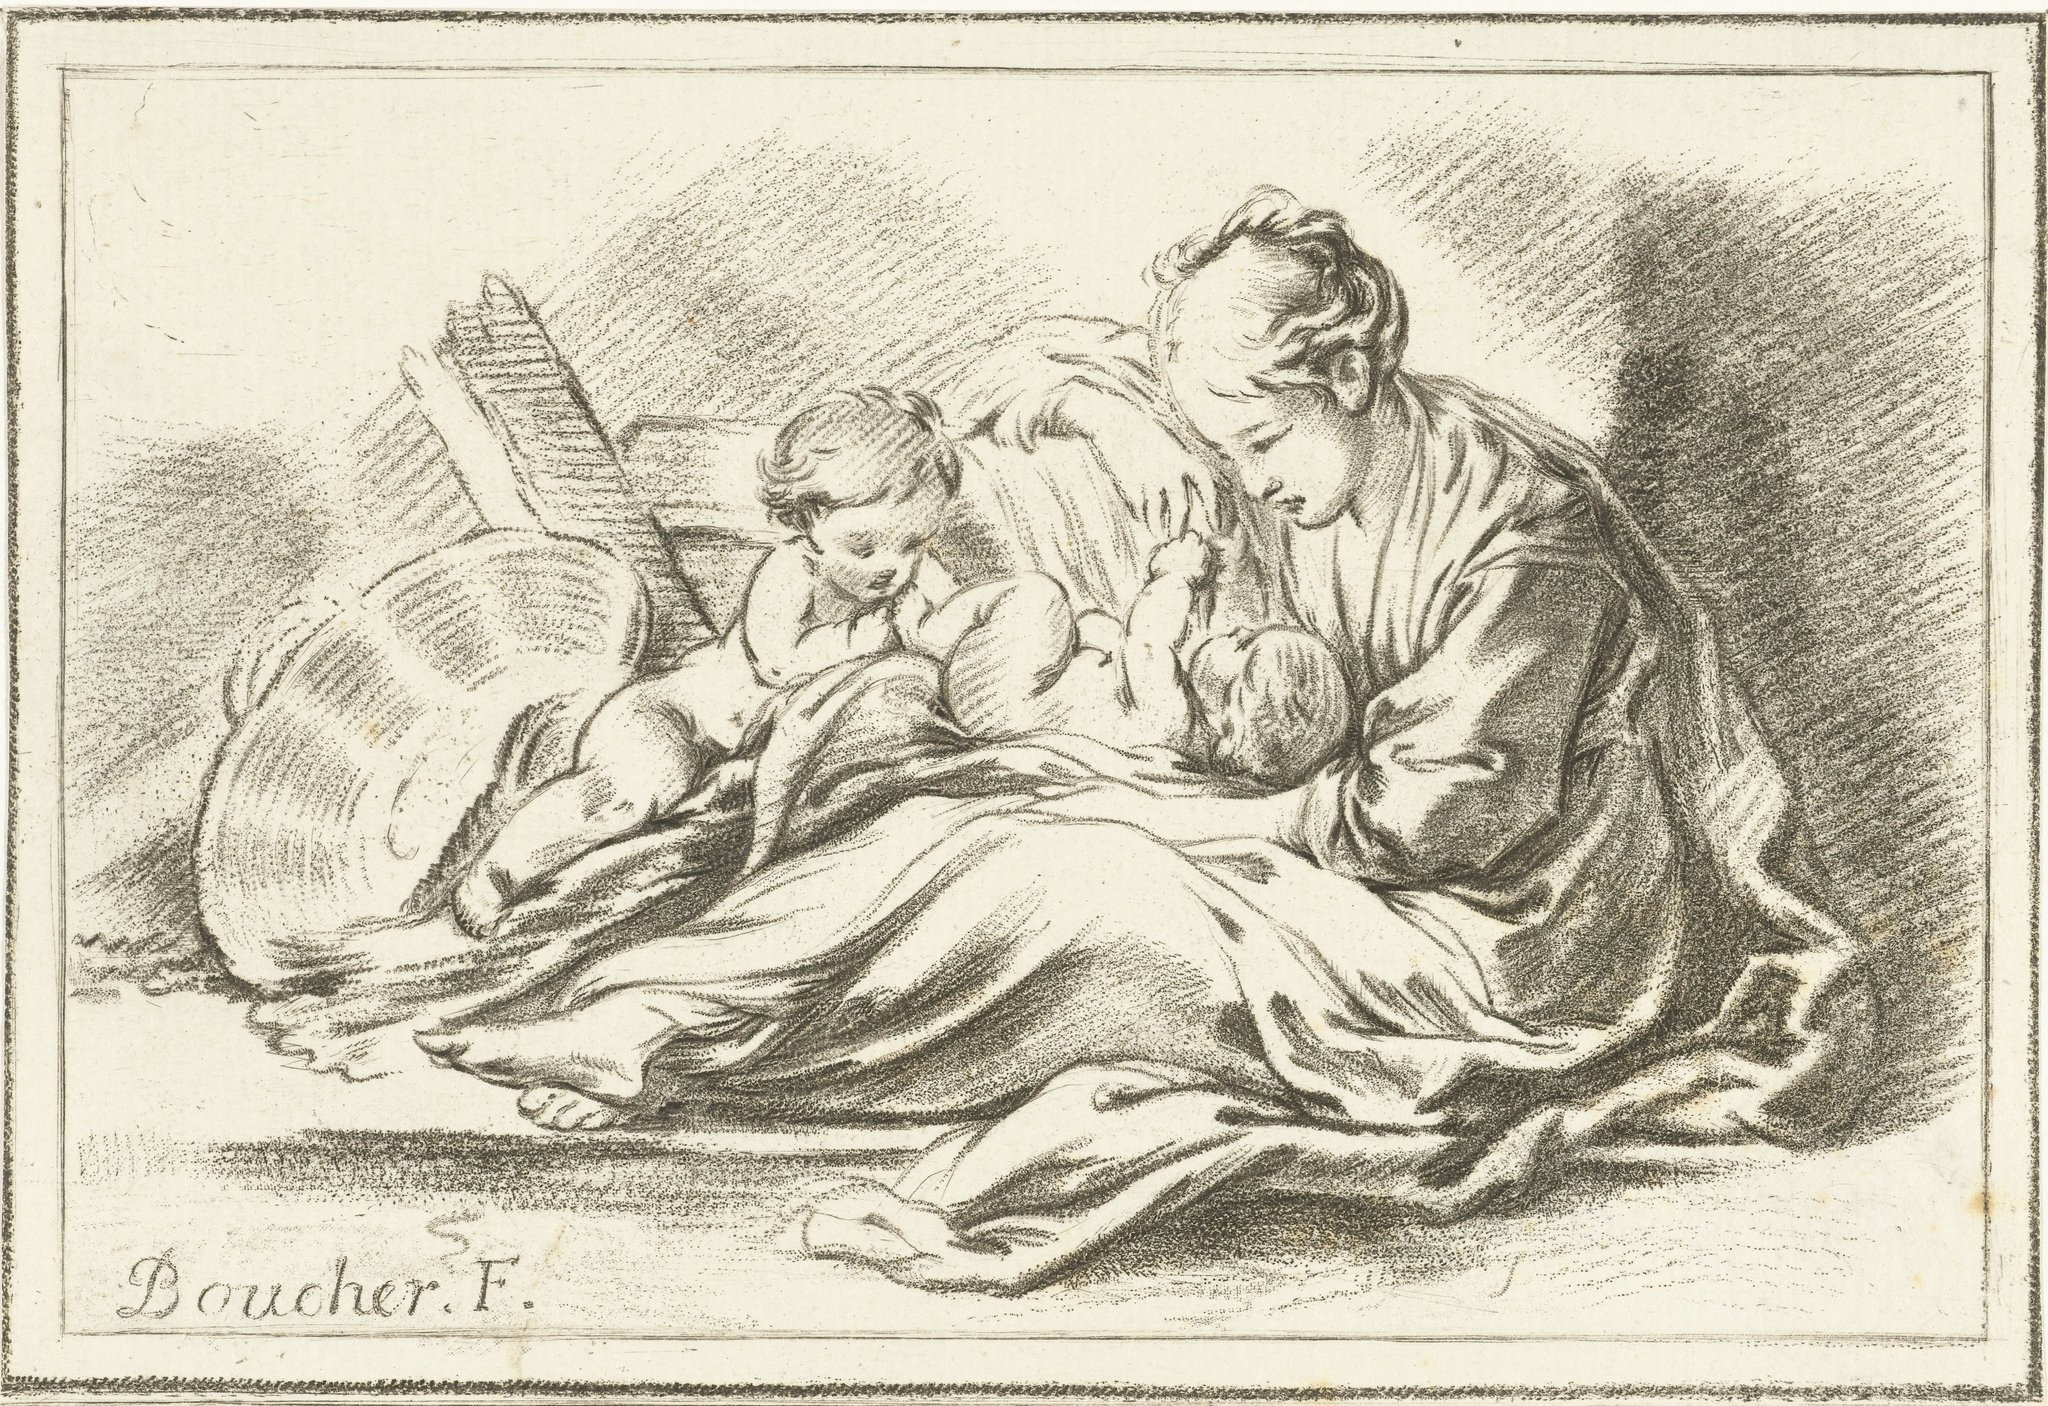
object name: print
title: Moeder en twee kinderen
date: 1724-1798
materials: paper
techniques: printmaking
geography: paris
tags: mother and baby or young child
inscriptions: collector's mark: Lugt 240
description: Een moeder zit op de grond naast een mand en houdt een baby in haar armen. Naast haar een ander kind.